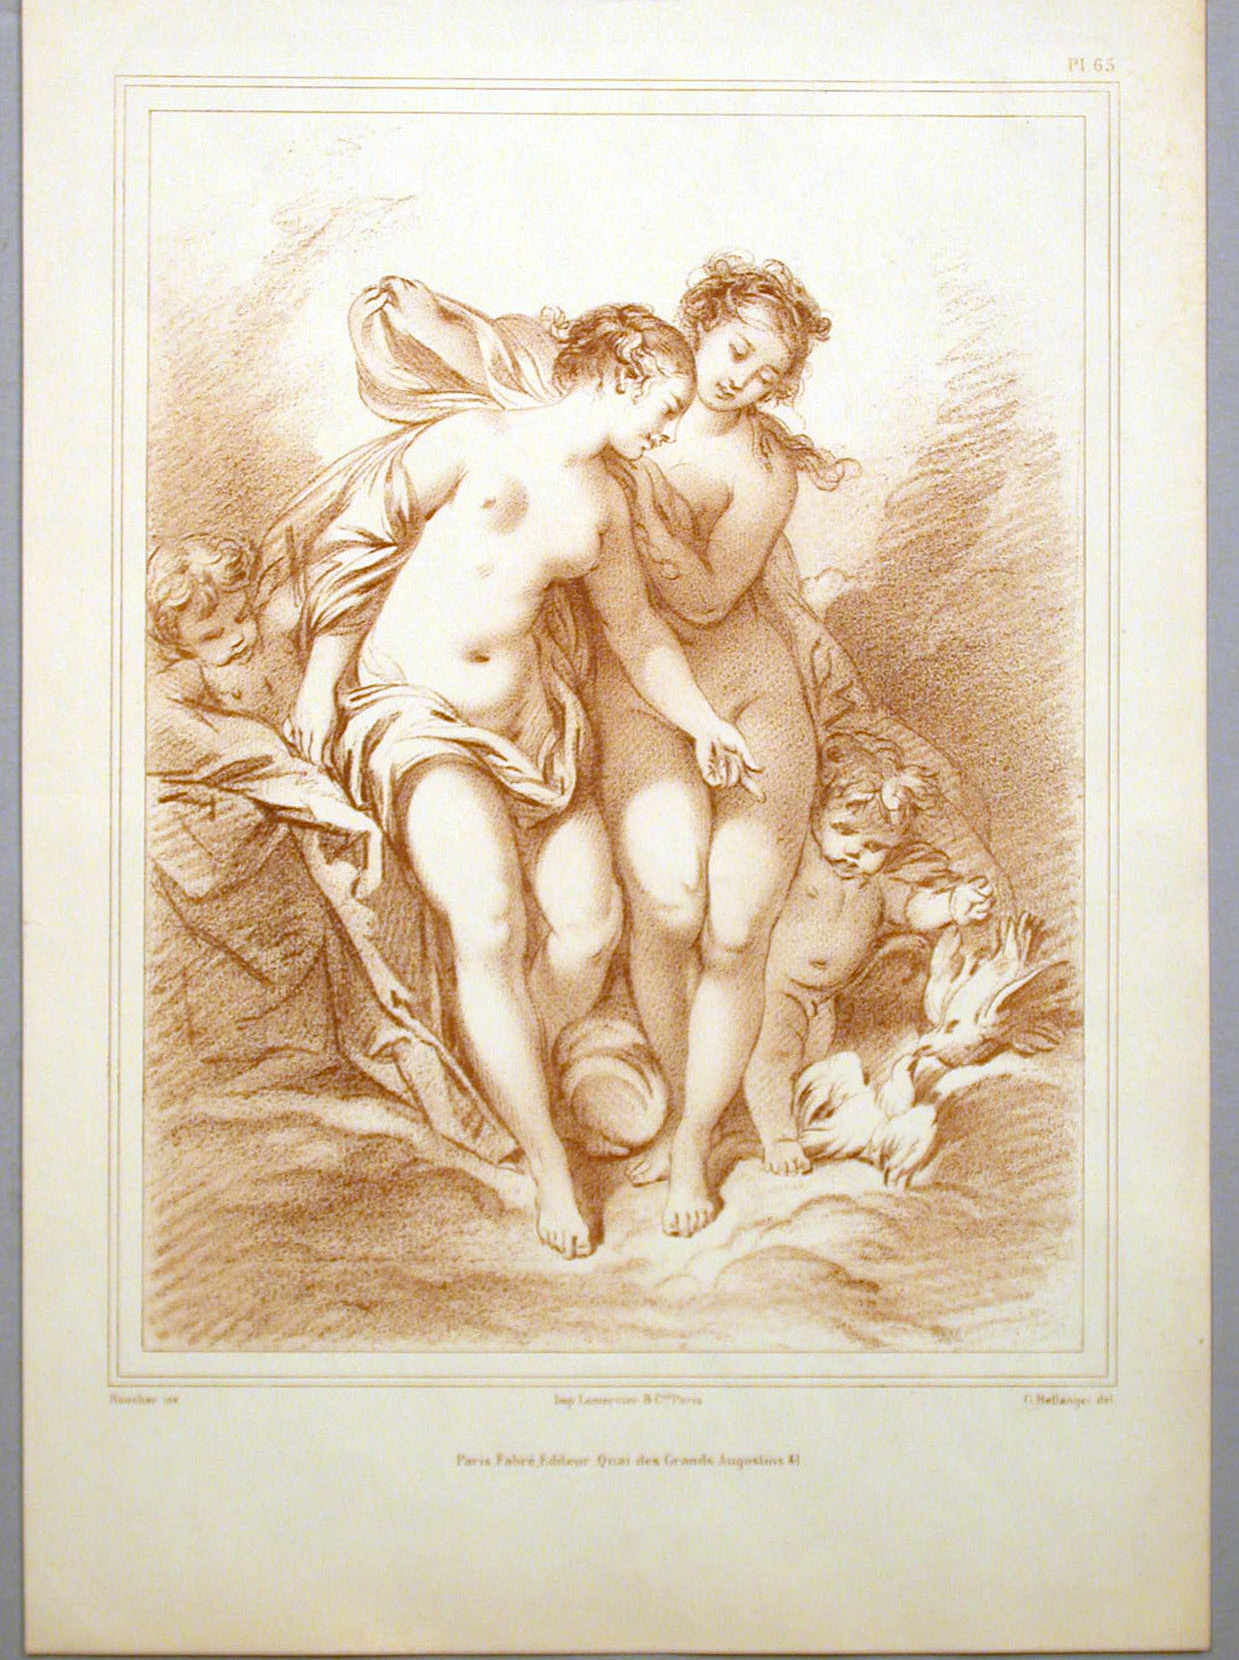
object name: print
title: Untitled: Two female nudes with two putti and doves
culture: french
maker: after bellanger (?)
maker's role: artist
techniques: lithograph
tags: doves,putti